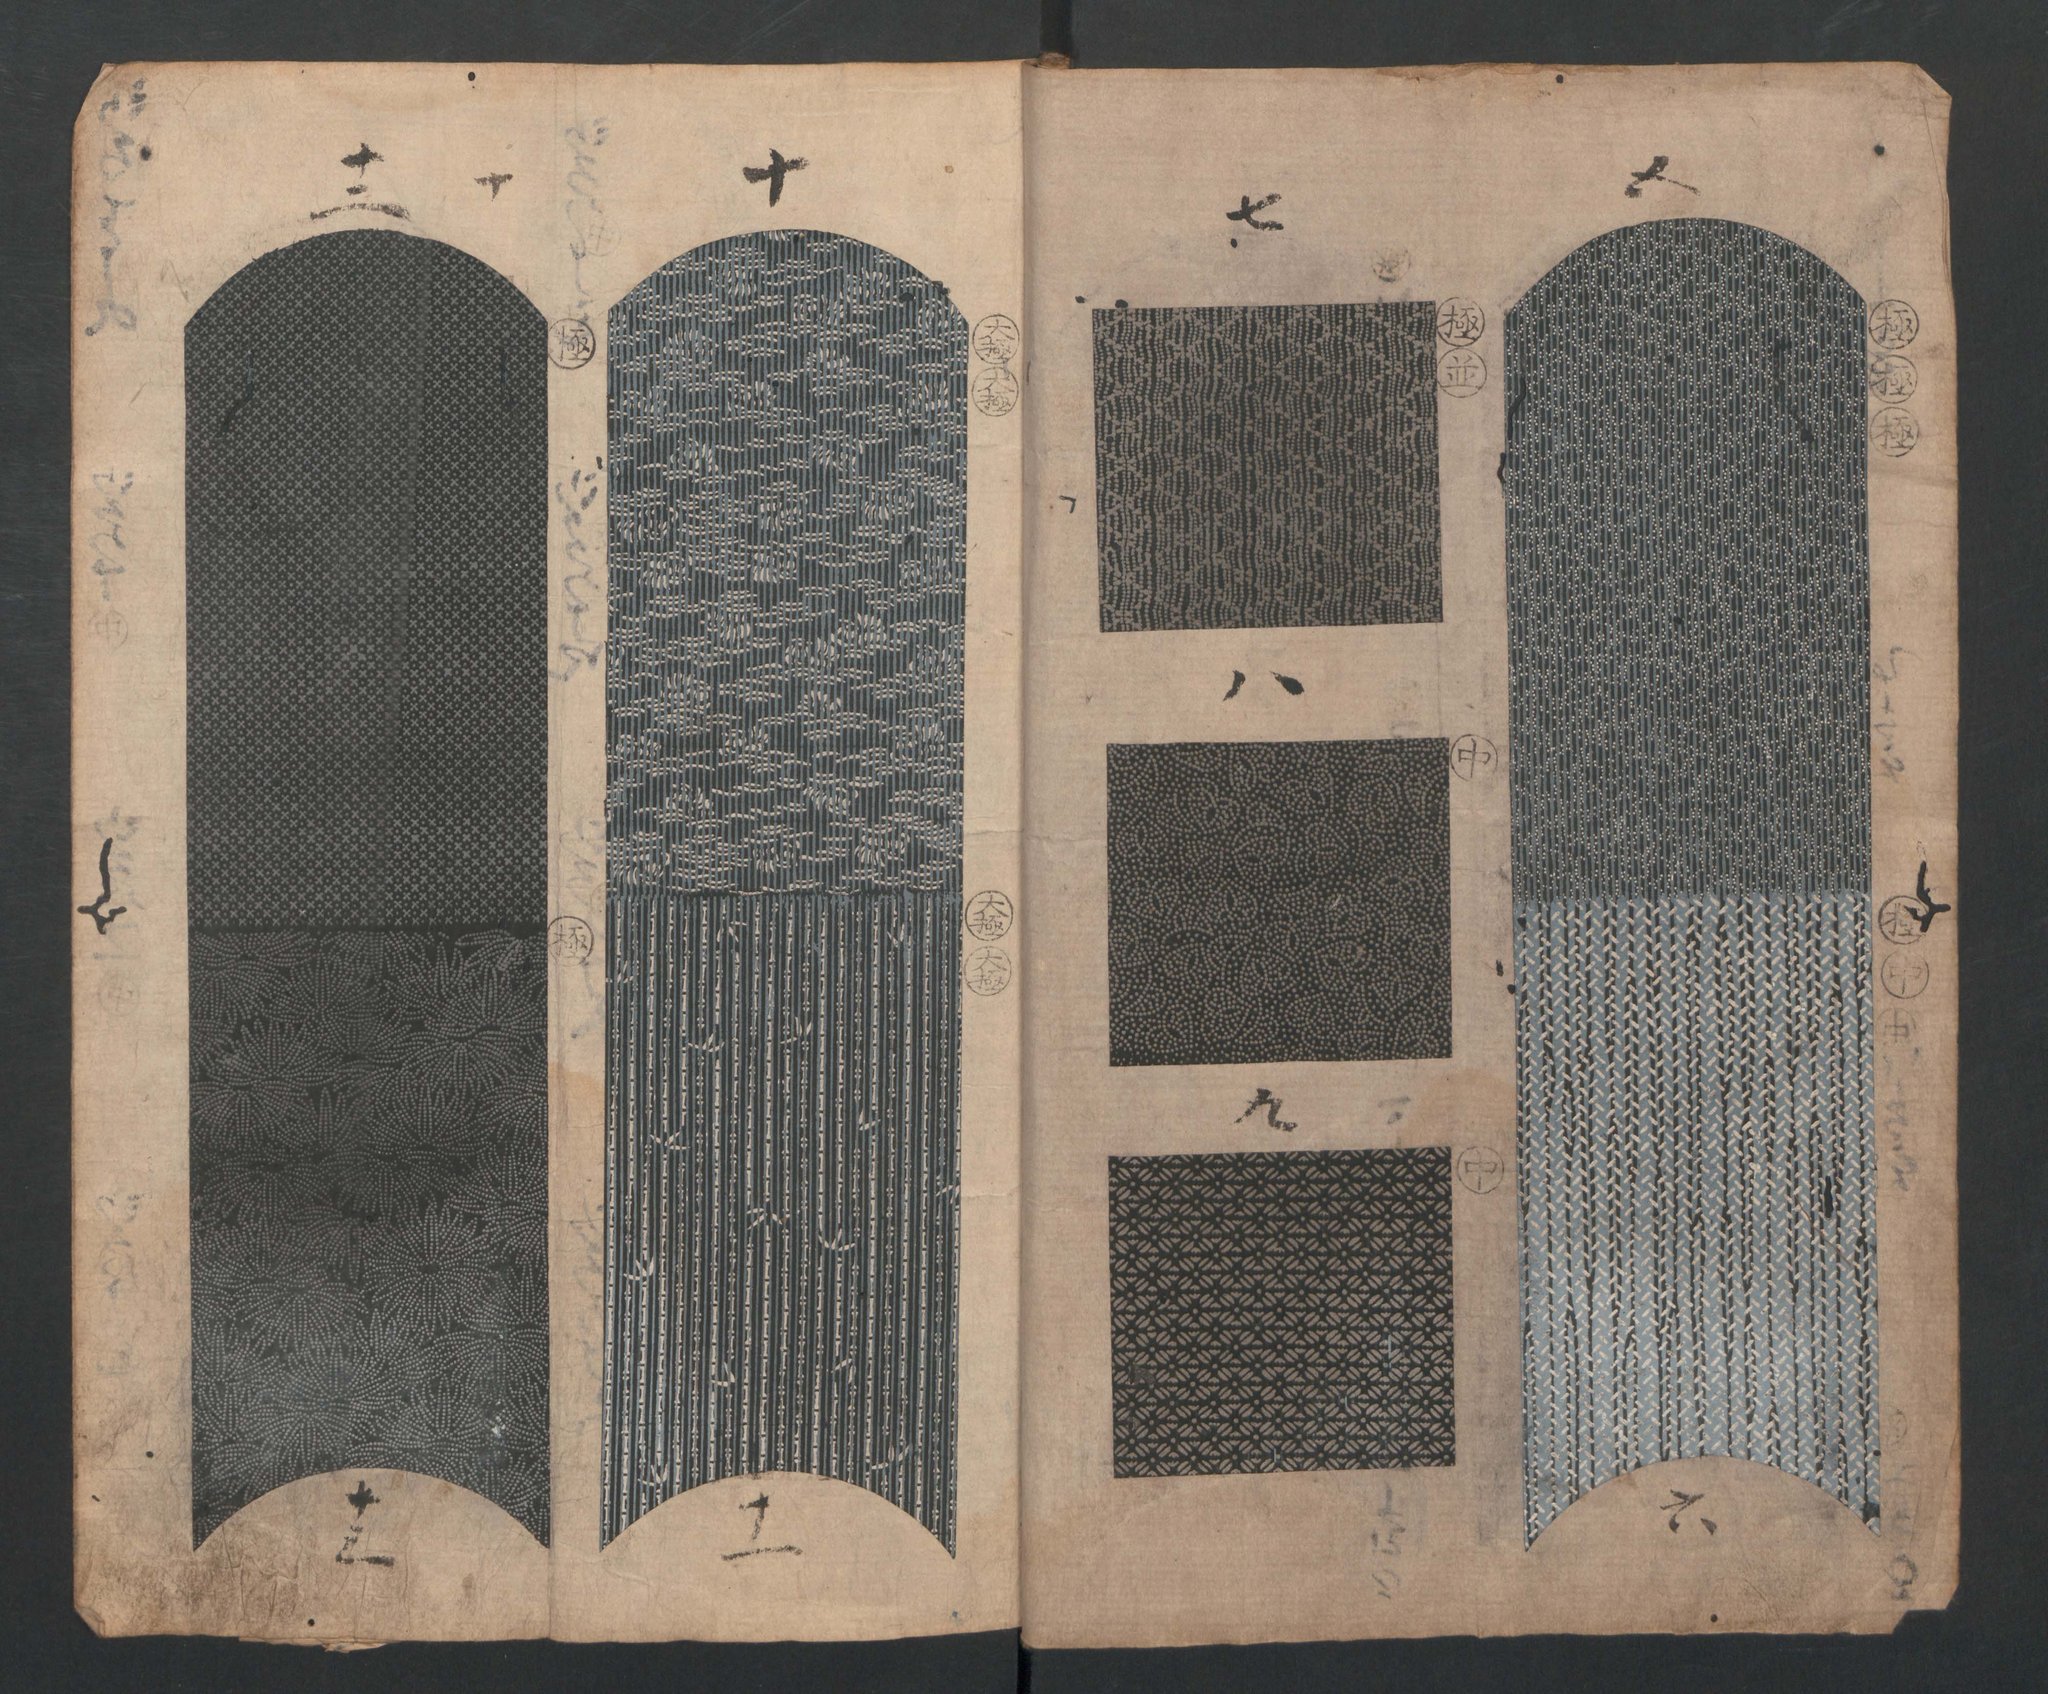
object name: illustrated book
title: Book of Designs (Tsuchinoto shinsen Komon chō) 己新撰 小紋帳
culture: japanese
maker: unidentified artist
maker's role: artist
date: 1660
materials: ink, paper